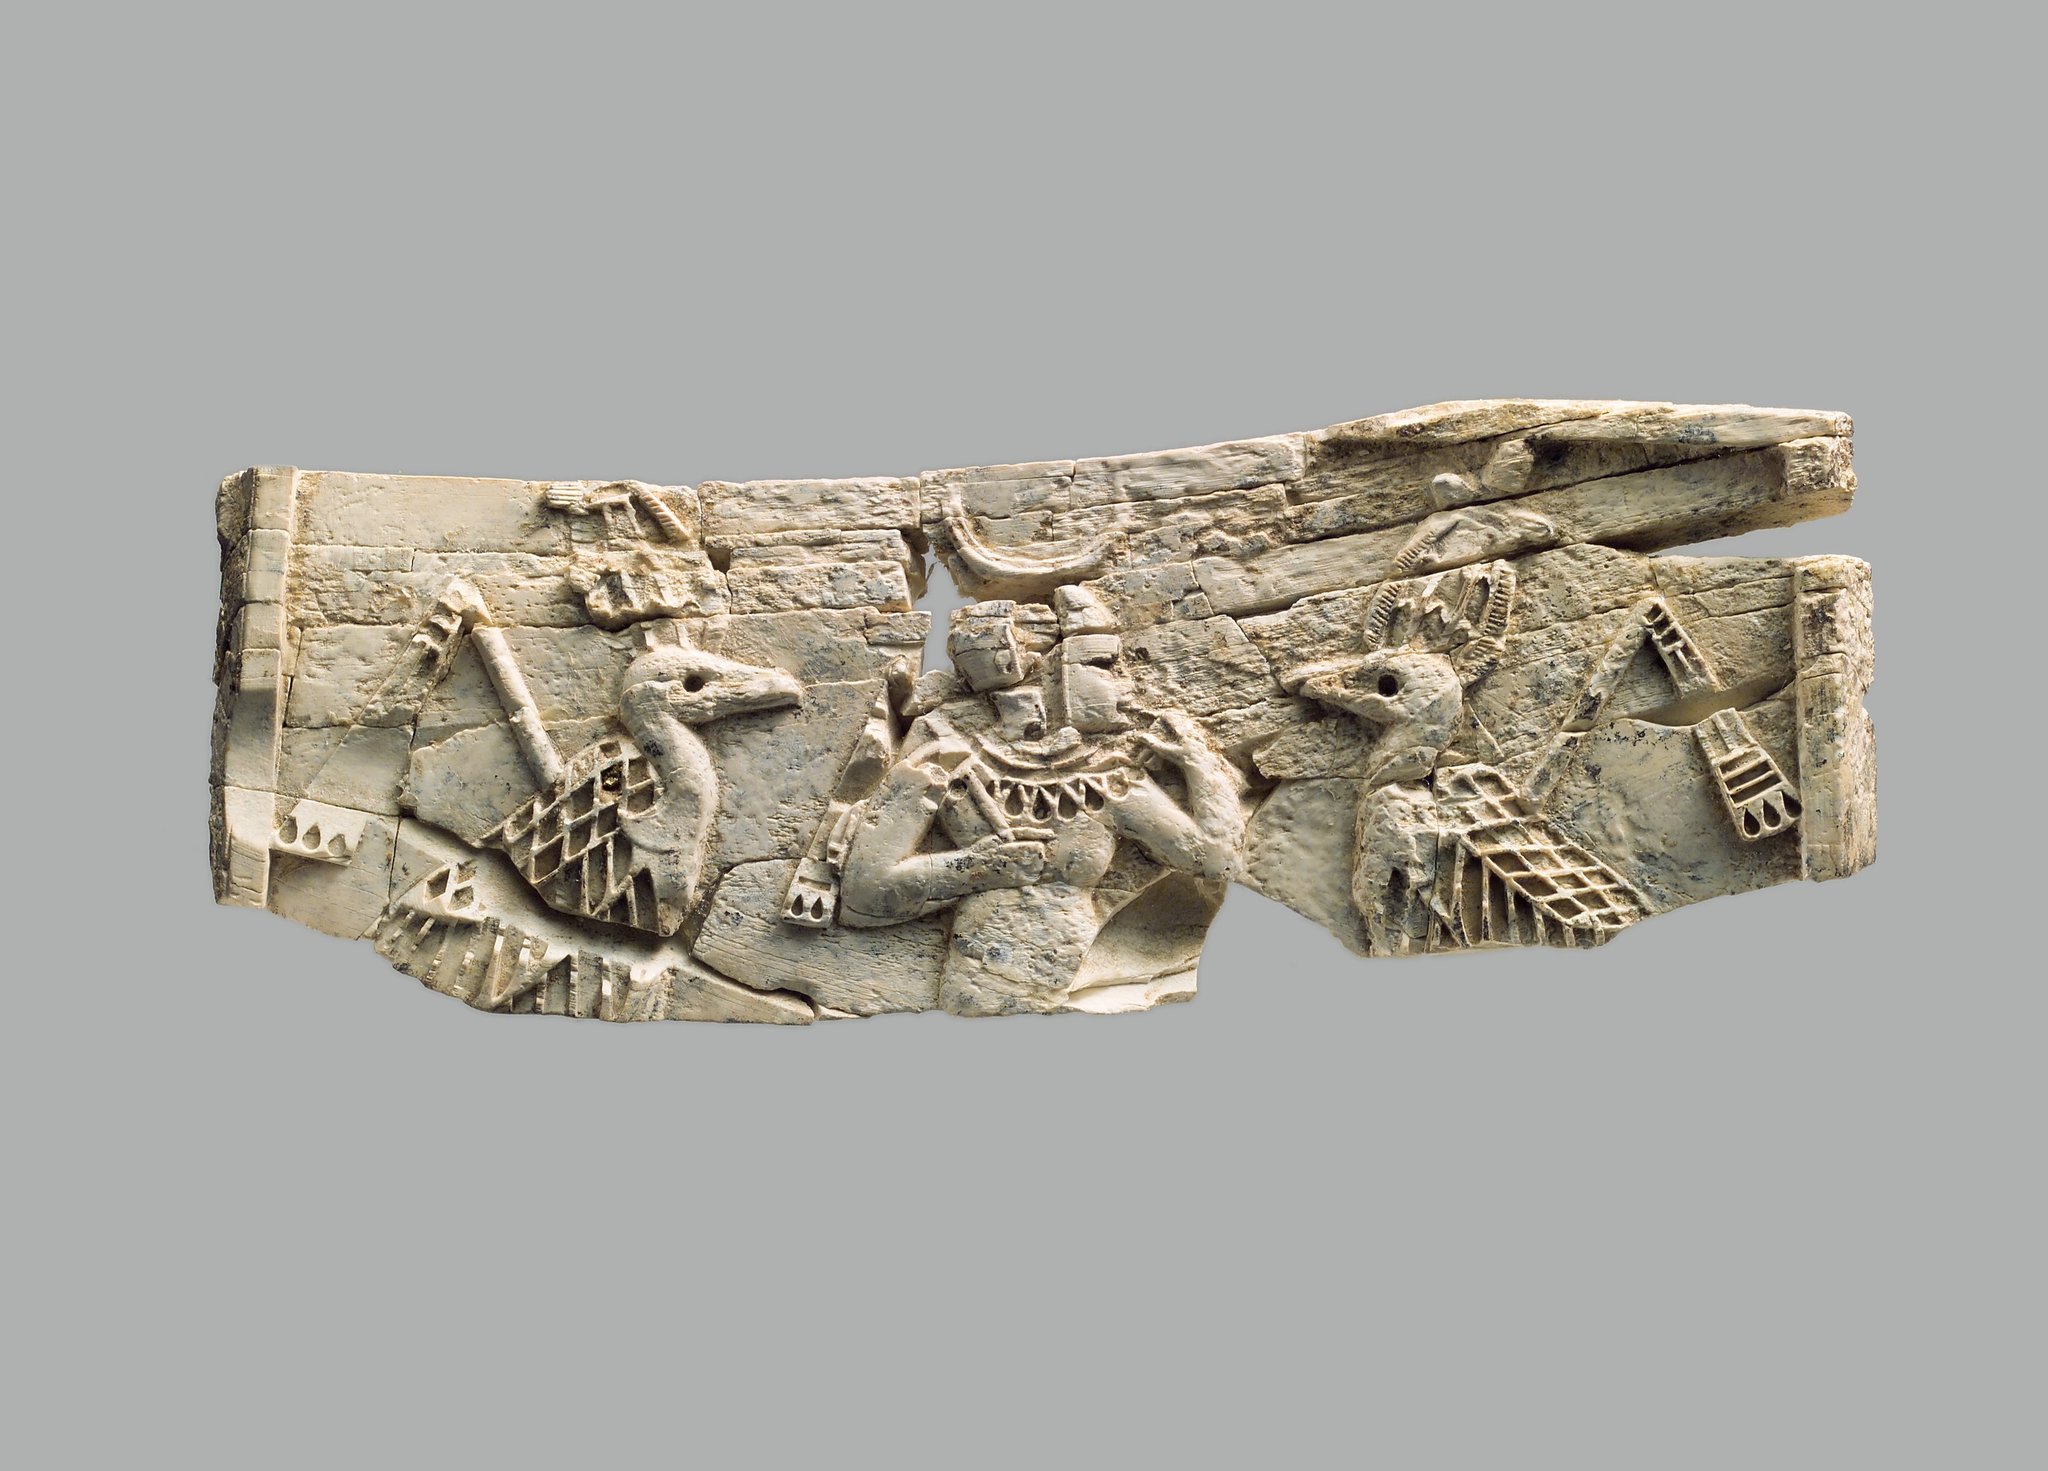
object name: furniture element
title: Cloisonne furniture plaques with the child Horus and vultures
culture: assyrian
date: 800-601 BCE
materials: ivory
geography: mesopotamia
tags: birds,horus